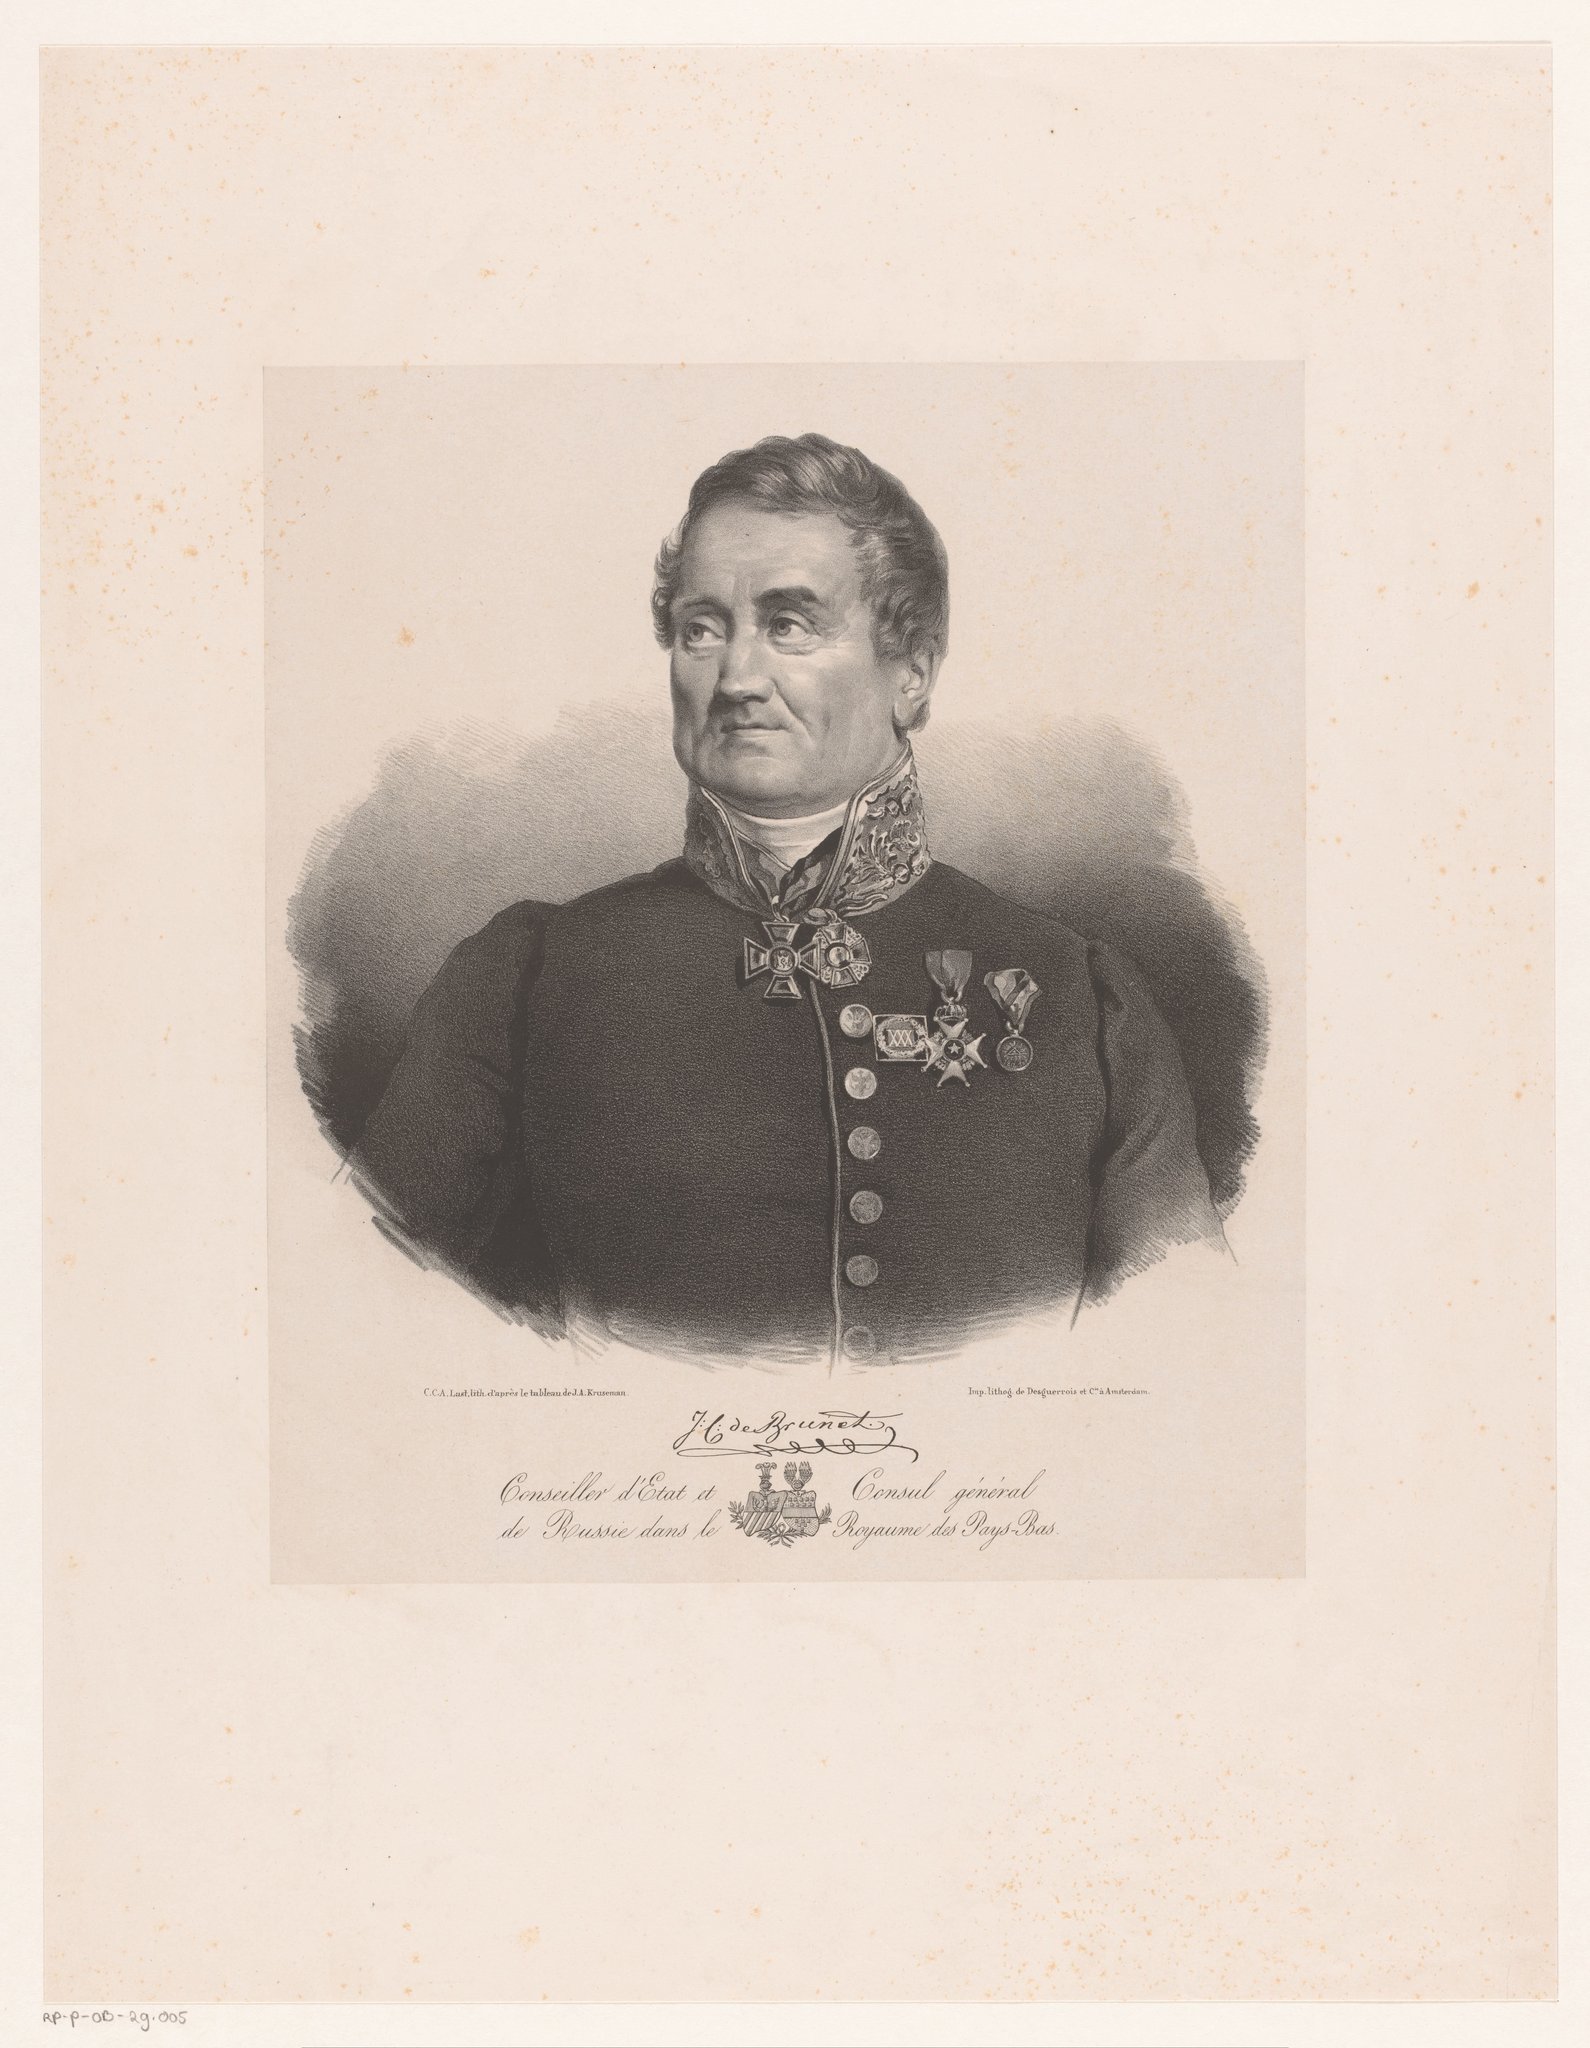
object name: print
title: Portret van Jean Casimir de Brunet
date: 1833-1876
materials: paper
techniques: lithograph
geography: netherlands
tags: knighthood order, historical persons (+ (full) bust portrait)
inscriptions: collector's mark: Lugt 2228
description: De geportretteerde draagt onderscheidingen om zijn hals en op zijn borst. Onder het portret zijn signatuur, familiewapens en beroep.